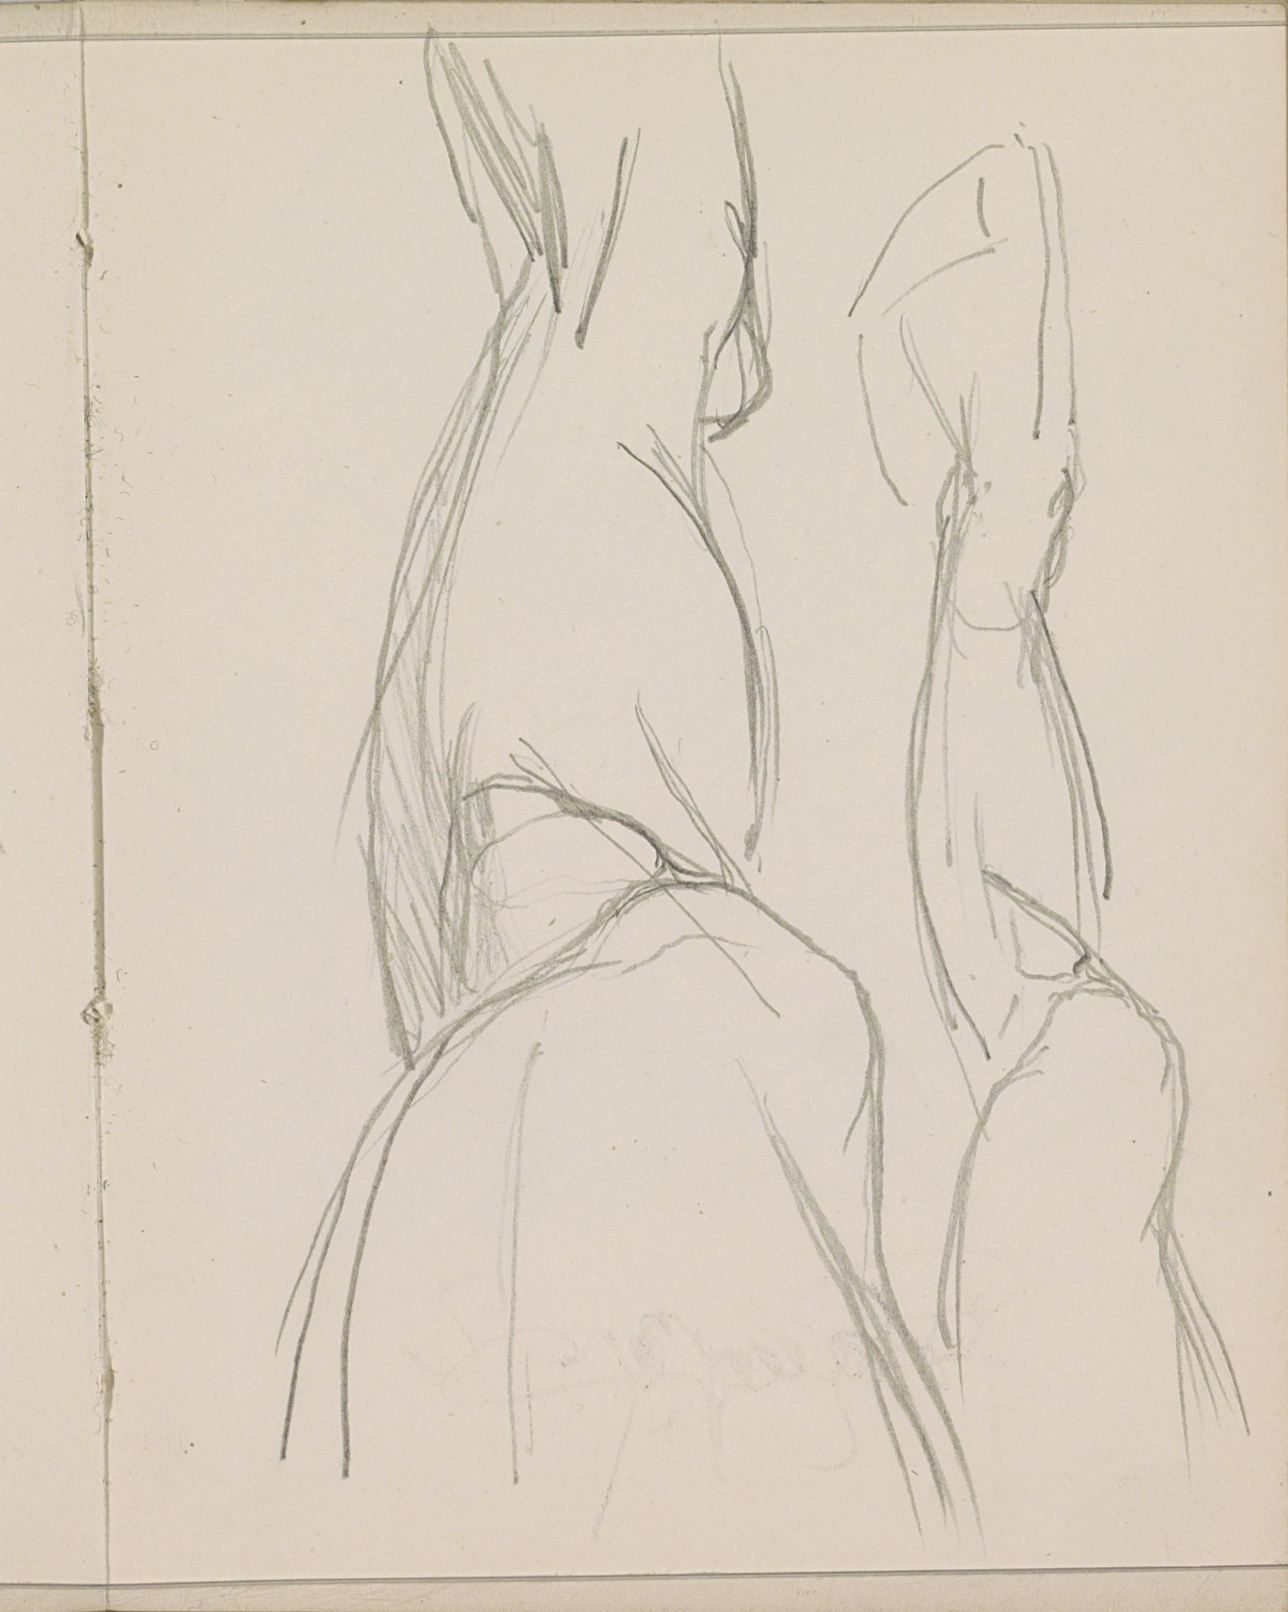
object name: sketchbook leaf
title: Benen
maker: reijer stolk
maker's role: draughtsman, print maker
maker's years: 1896-1945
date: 1916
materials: paper, pencil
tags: muscles, legs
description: Blad 8 verso uit een schetsboek met 72 bladen.